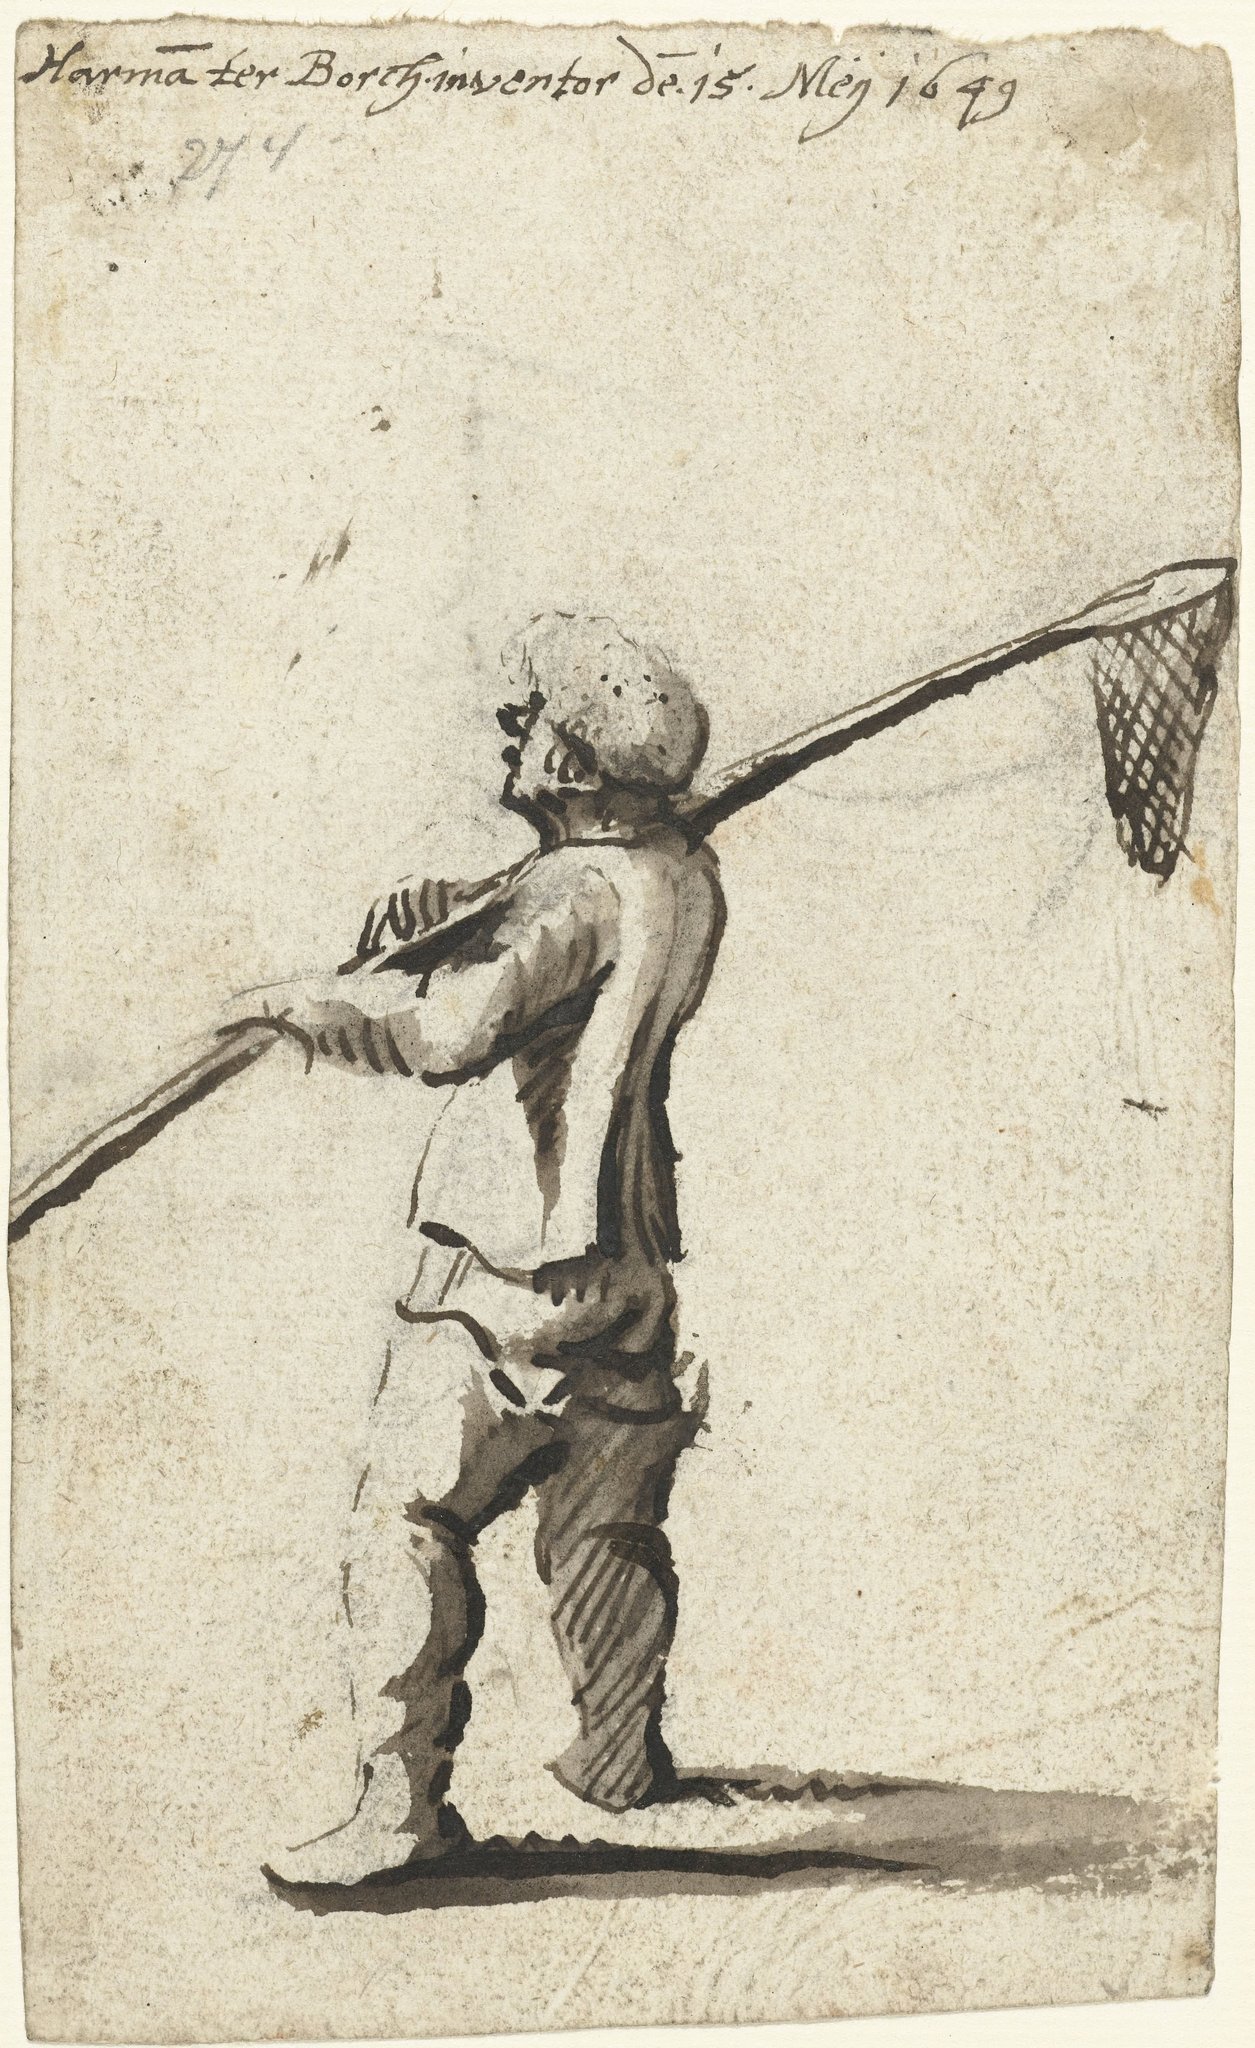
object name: drawing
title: Visser met laarzen en een visnet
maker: harmen ter borch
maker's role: draughtsman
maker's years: 1638-1677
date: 1649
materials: chalk, ink, paper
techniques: brush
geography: zwolle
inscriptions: annotation: ‘Harma[n] ter Borch. inventor de[n]. 15.Meij 1649’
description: Visser met lange laarzen en een visnet aan een stok over zijn schouder.